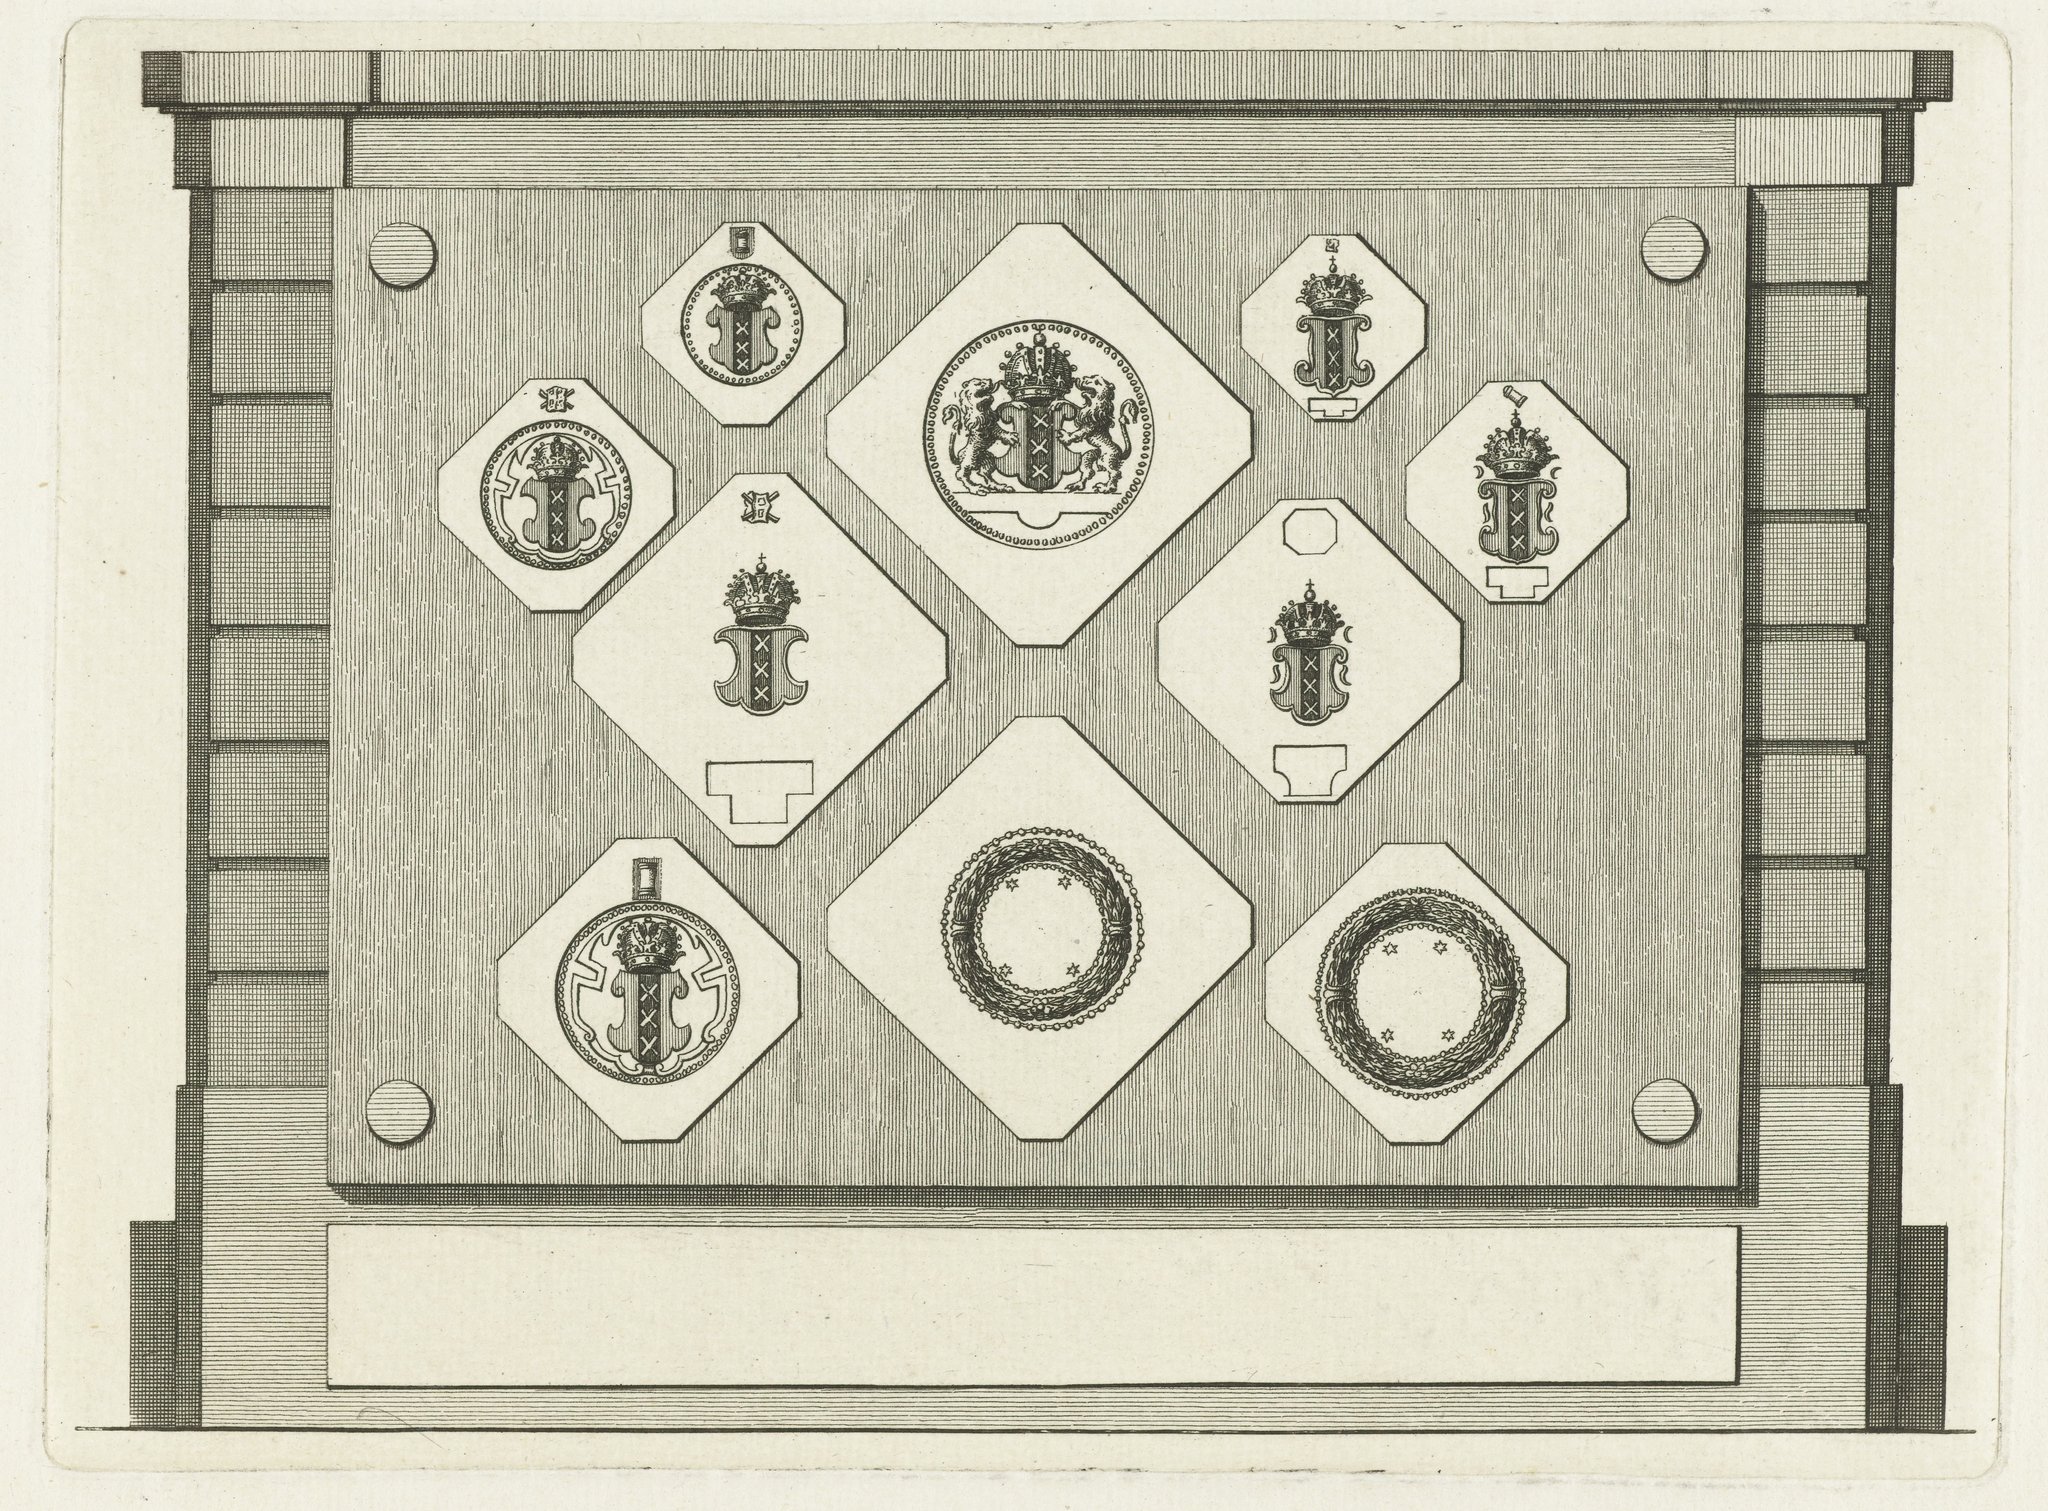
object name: print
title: Noodmunten uit Amsterdam, 1578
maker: caspar jacobsz. philips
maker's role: draughtsman, print maker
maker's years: 1732-1789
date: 1752-1789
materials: paper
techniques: etching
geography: amsterdam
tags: coin, amsterdam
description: Volgens Muller gebruikt als illustratie in Wagenaars geschiedenis van Amsterdam. Dit lijkt niet te kloppen. Voor tweede bekende staat zie RP-P-OB-79.746.